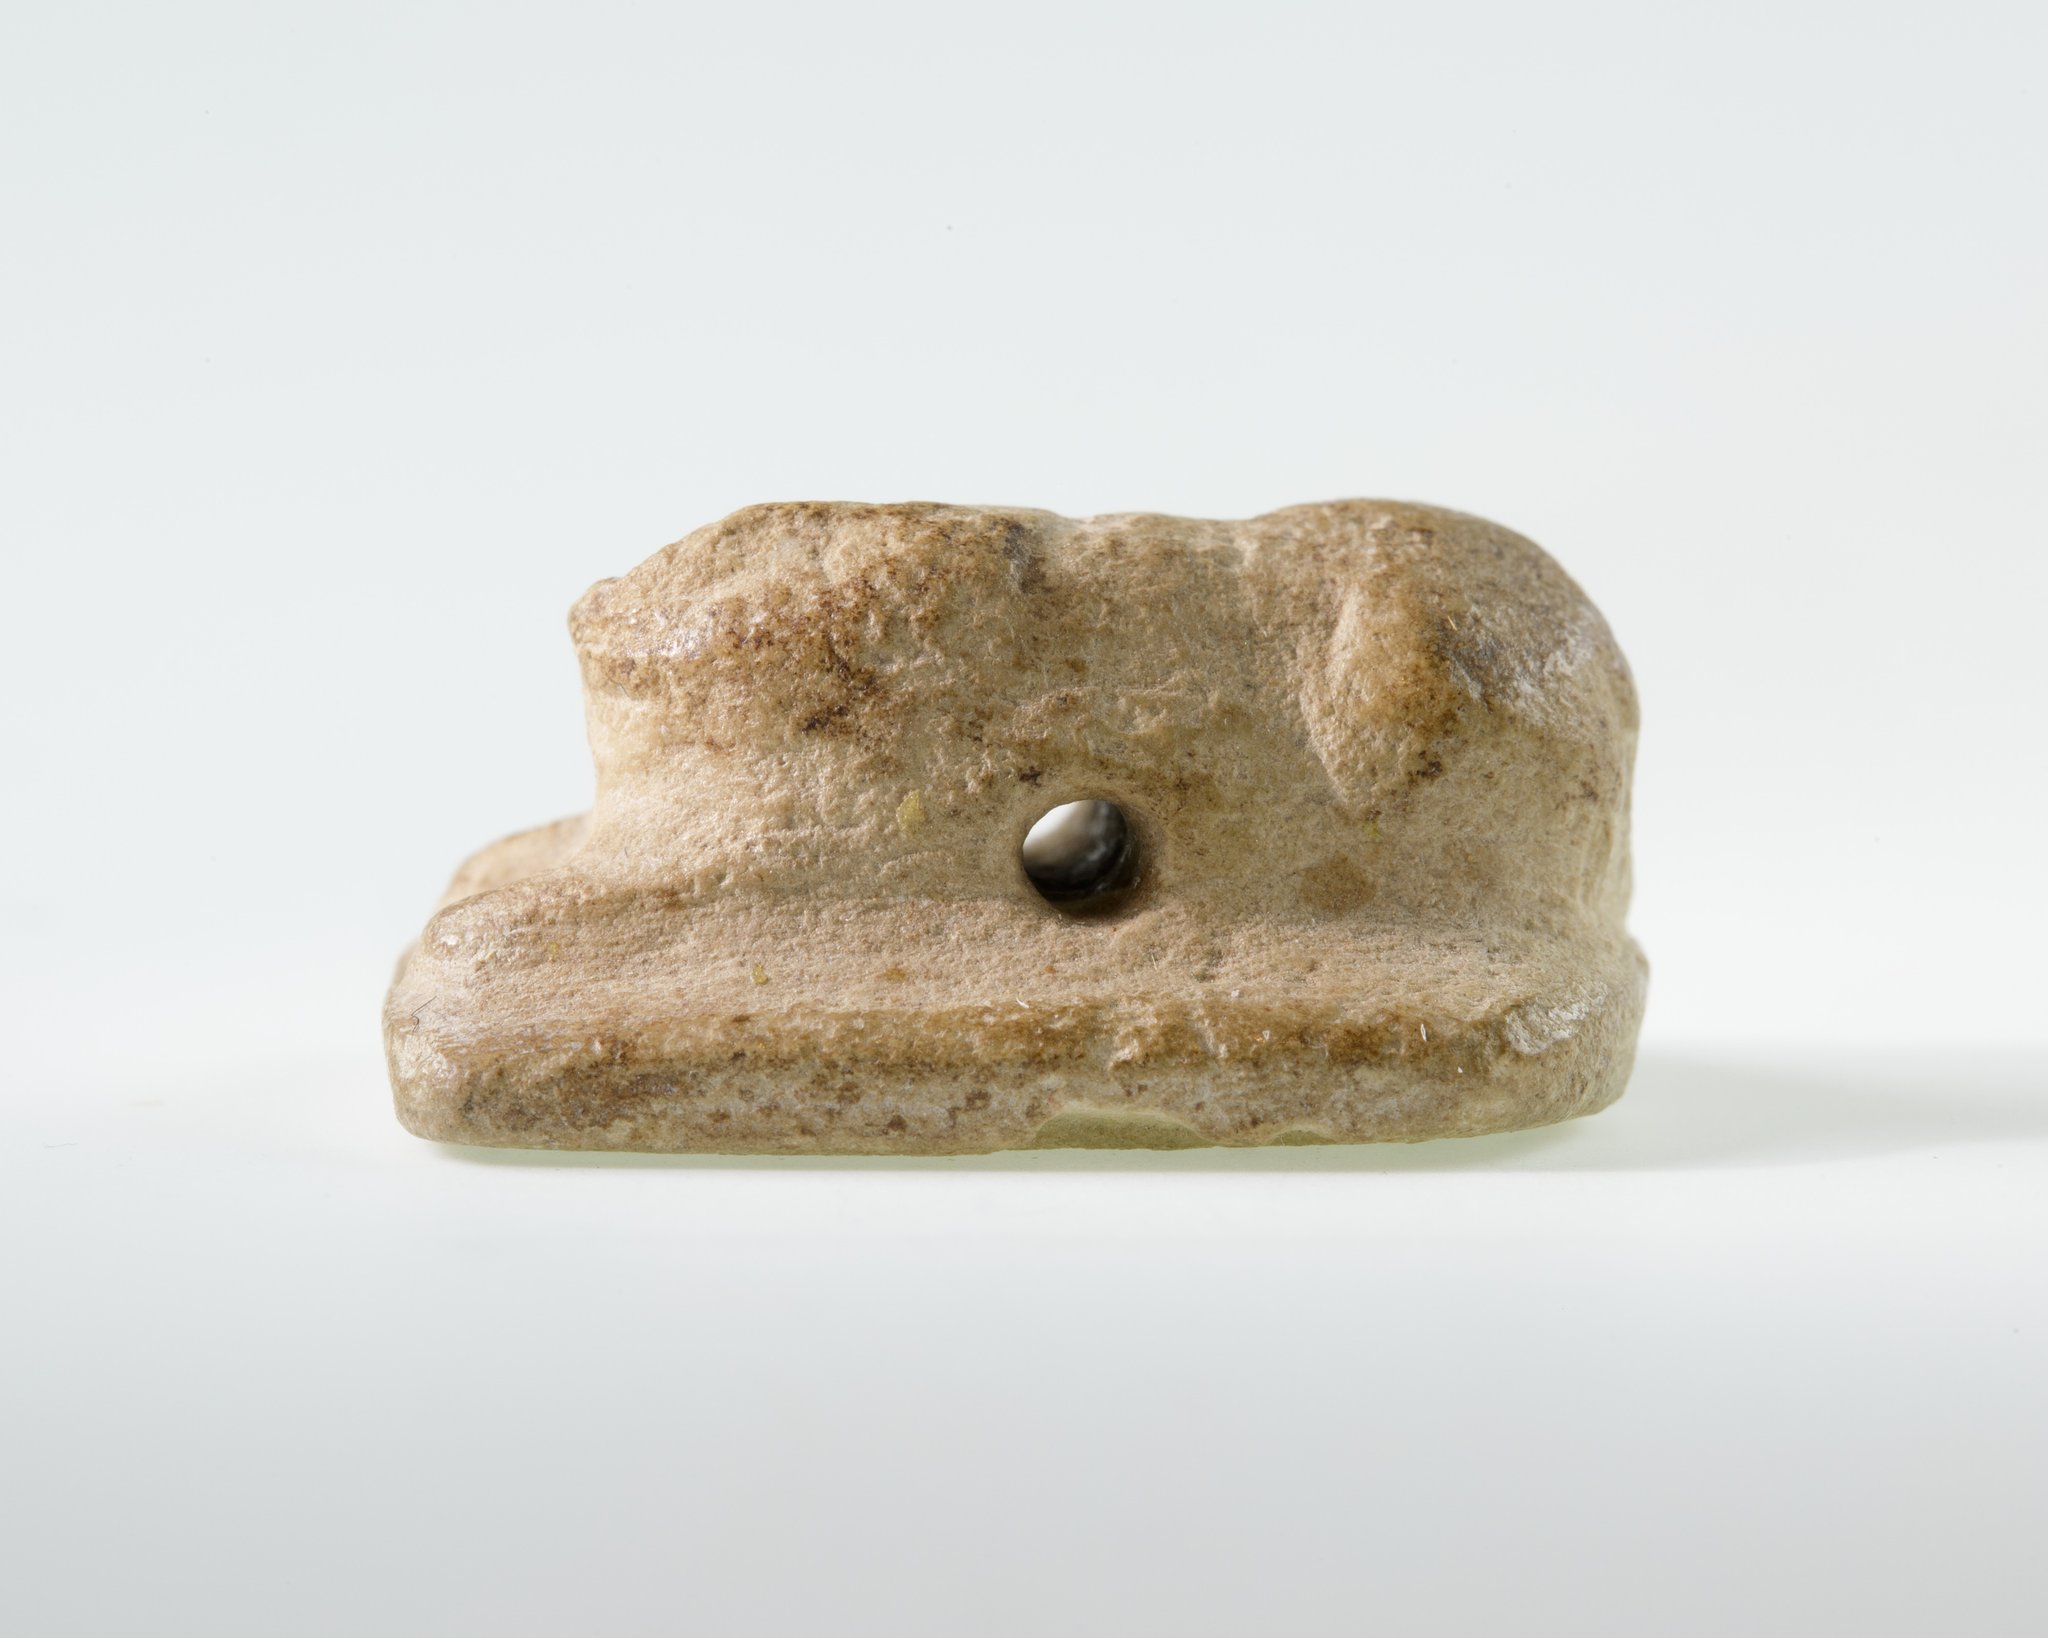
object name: seal, amenemhat ii, lion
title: Lion-shaped stamp seal with name of Amenemhat II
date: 1859-1813 BCE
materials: faience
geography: egypt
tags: lions